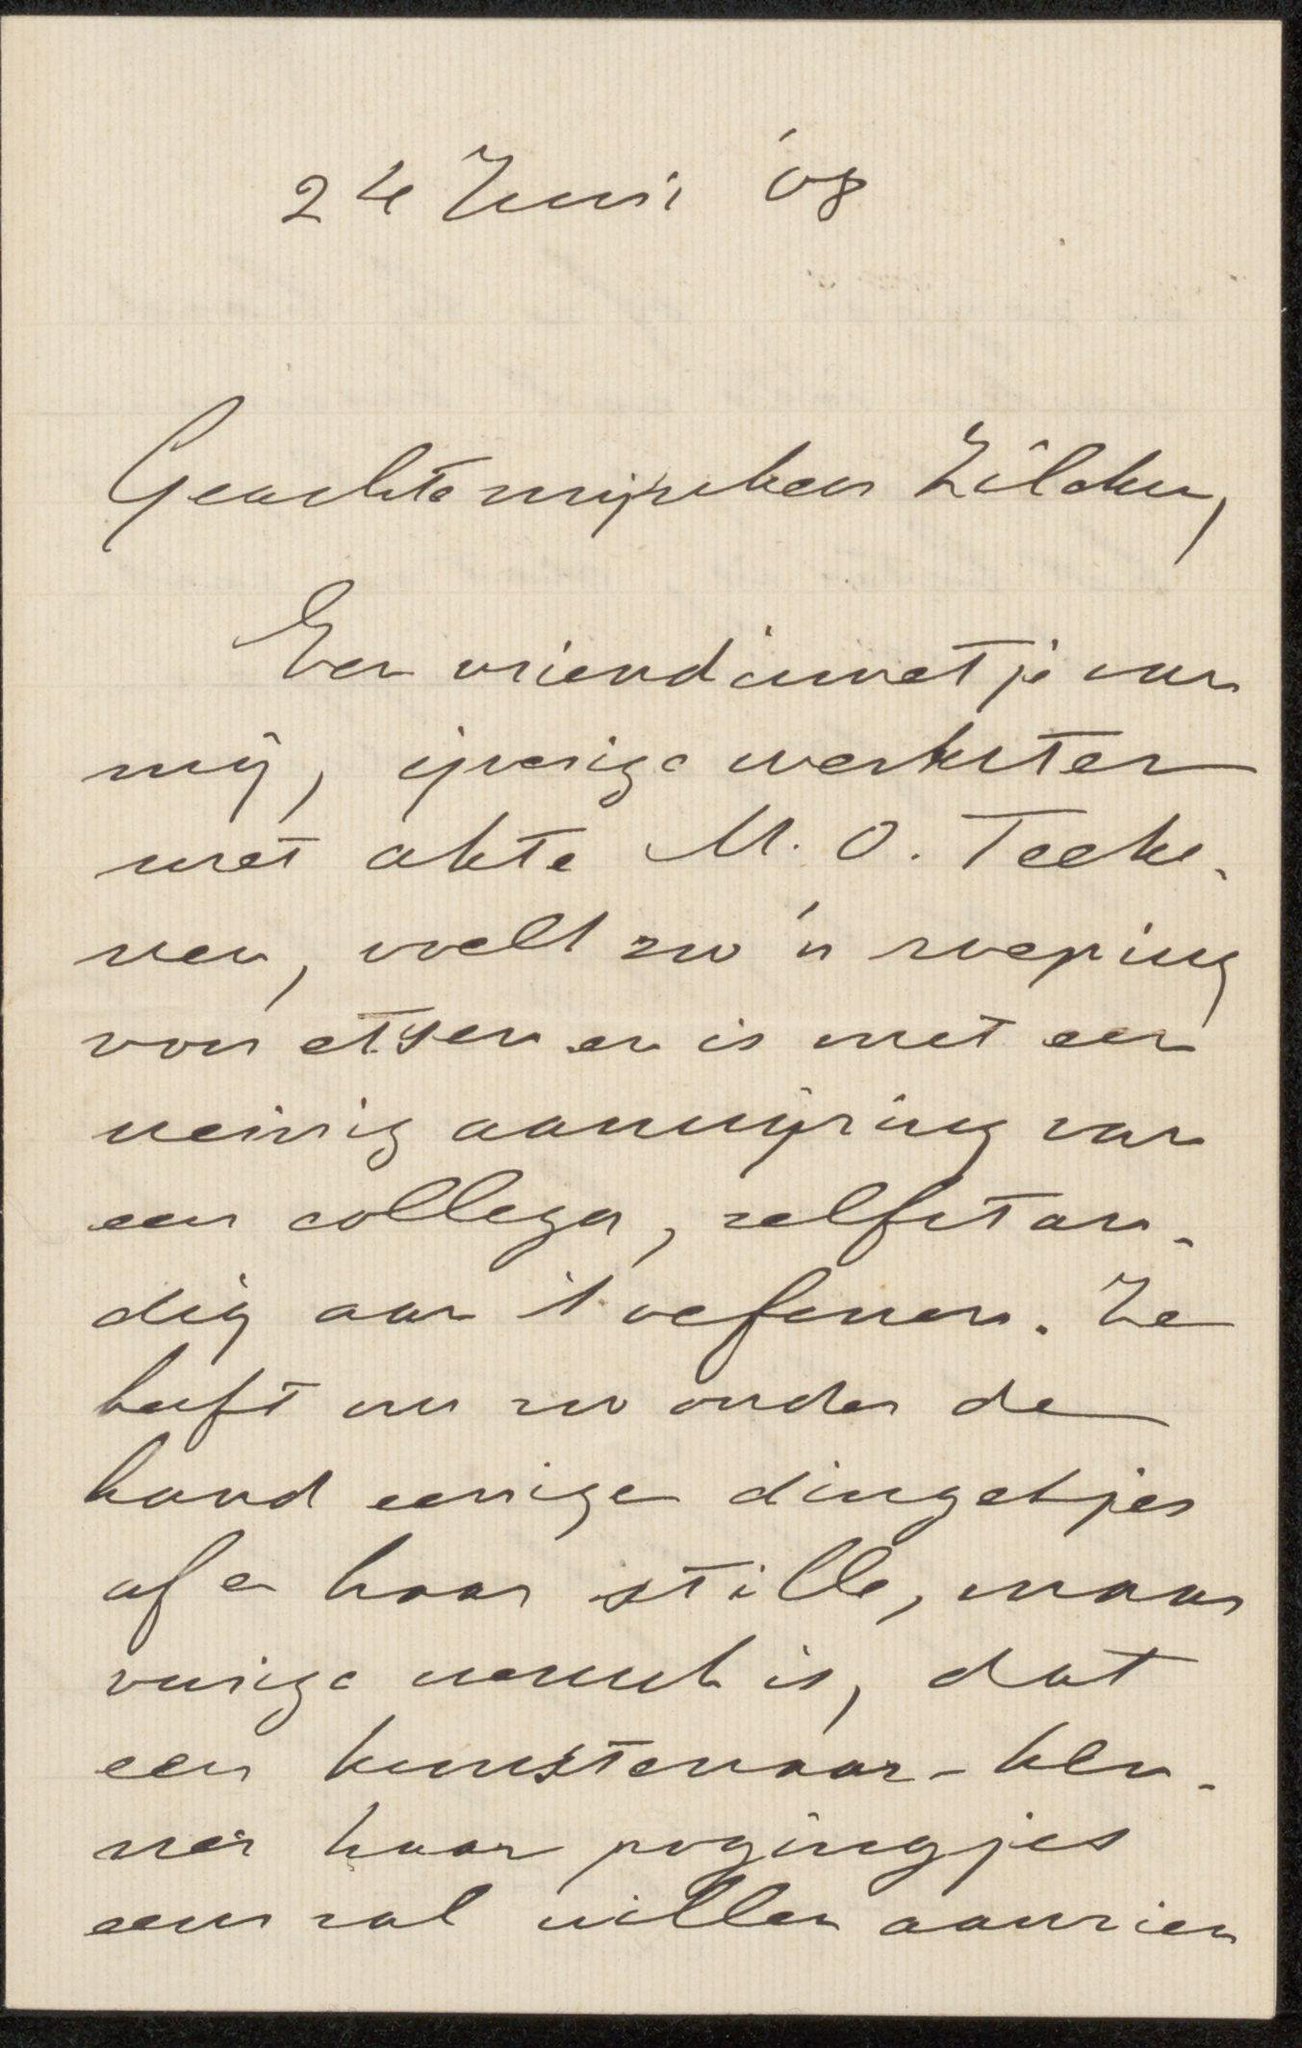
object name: letter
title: Brief aan Philip Zilcken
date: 1908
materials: ink, paper, pencil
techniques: pen, writing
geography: the hague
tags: painter, draughtsman, philip zilcken, the graphic arts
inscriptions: collector's mark: ‘RPK’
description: Aantekeningen van Philip Zilcken op envelop verso.